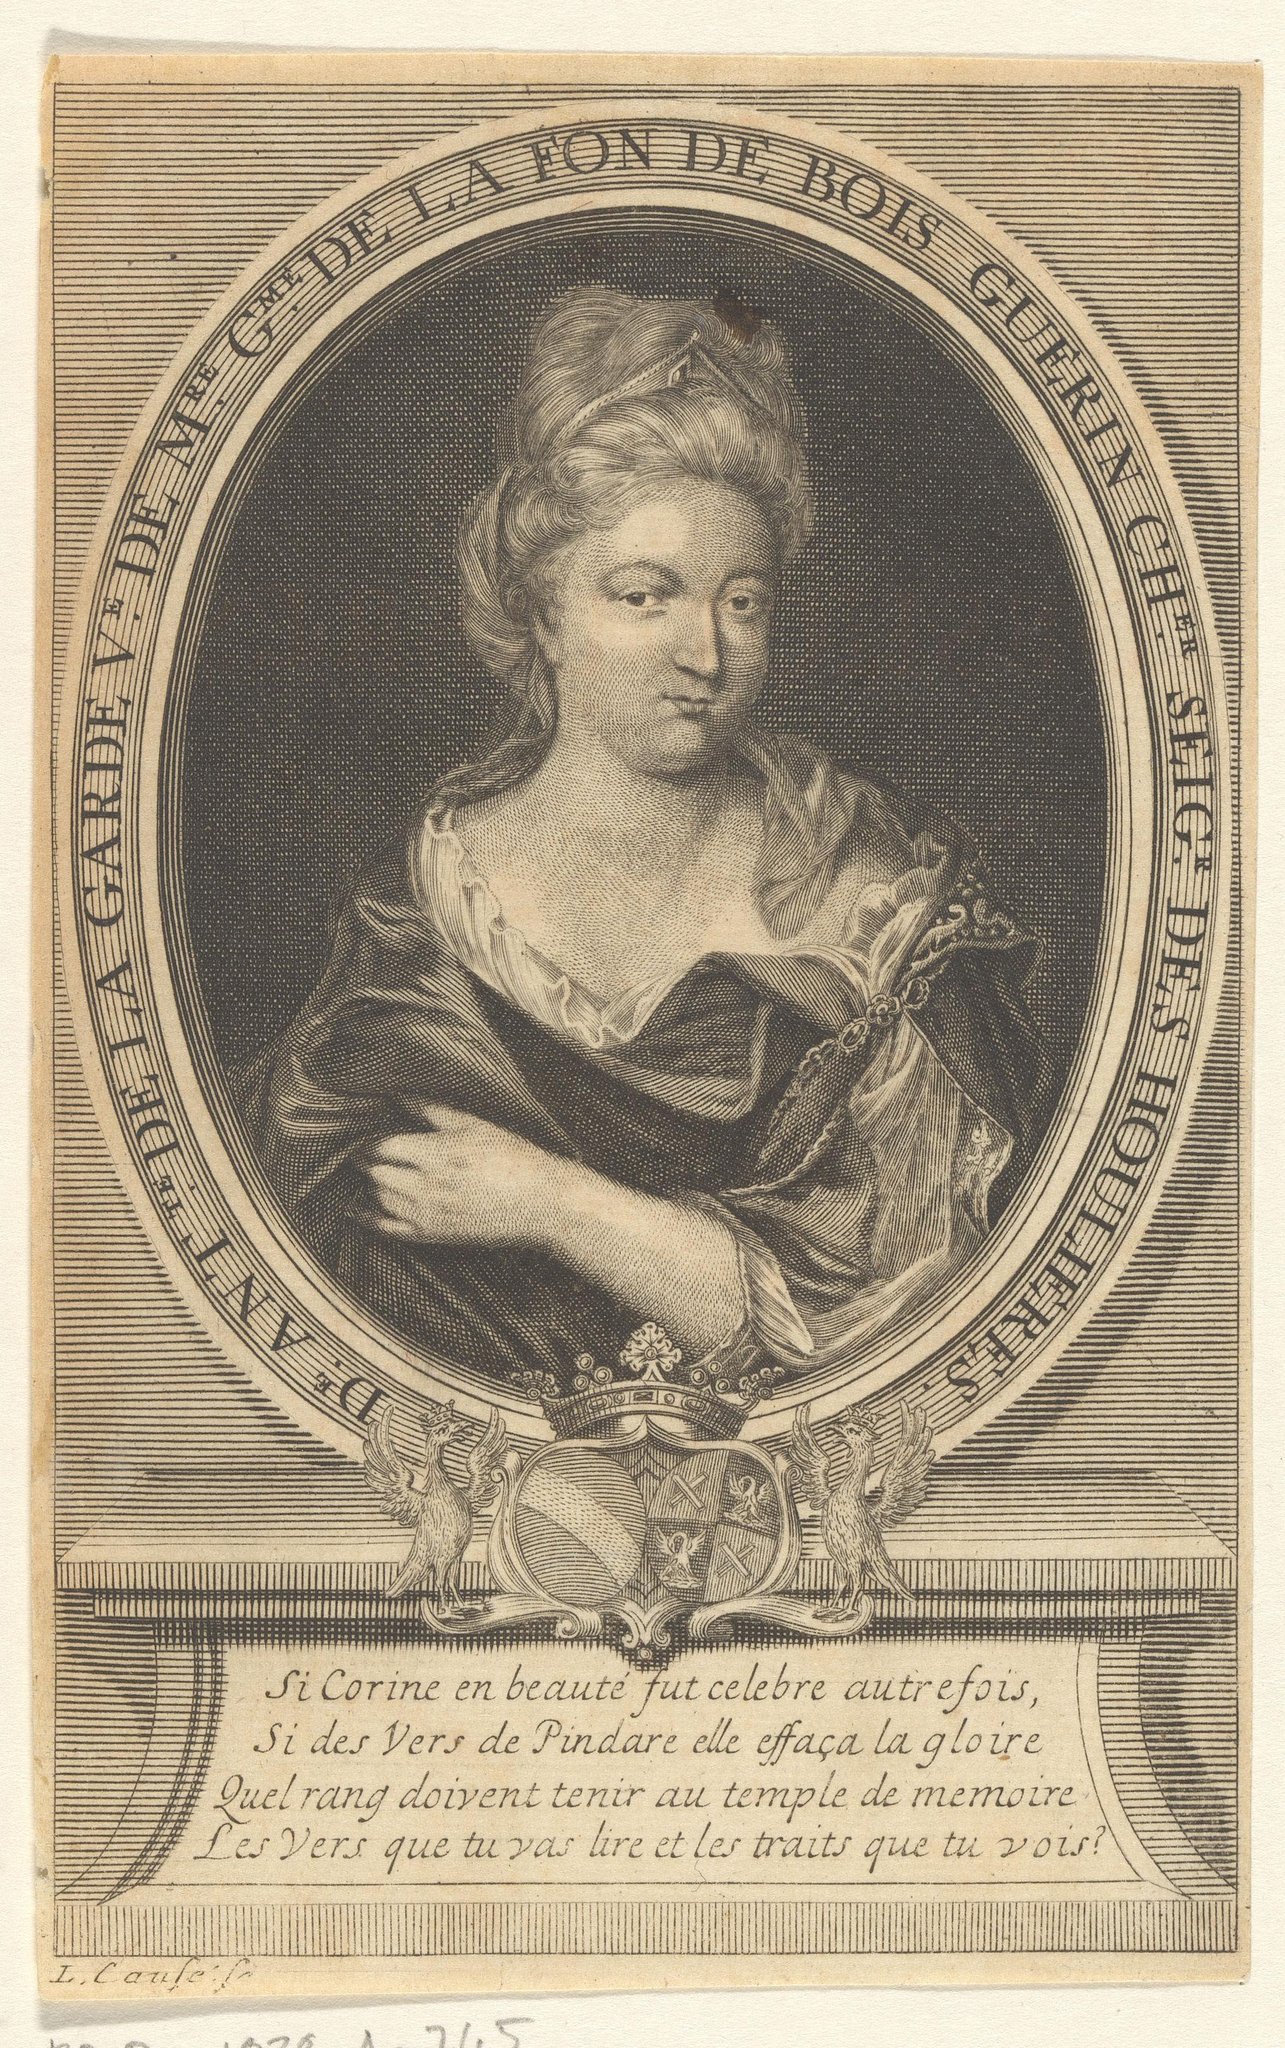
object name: print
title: Portret van Antoinette Du Ligier de la Garde Deshoulières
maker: lamberecht causé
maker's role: print maker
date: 1675-1700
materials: paper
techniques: engraving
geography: netherlands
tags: paris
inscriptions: collector's mark: Lugt 2228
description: Portret van Antoinette Du Ligier de la Garde Deshoulières, in ovaal met randschrift. Onder het portret op een plint een Frans vers en haar familiewapen.